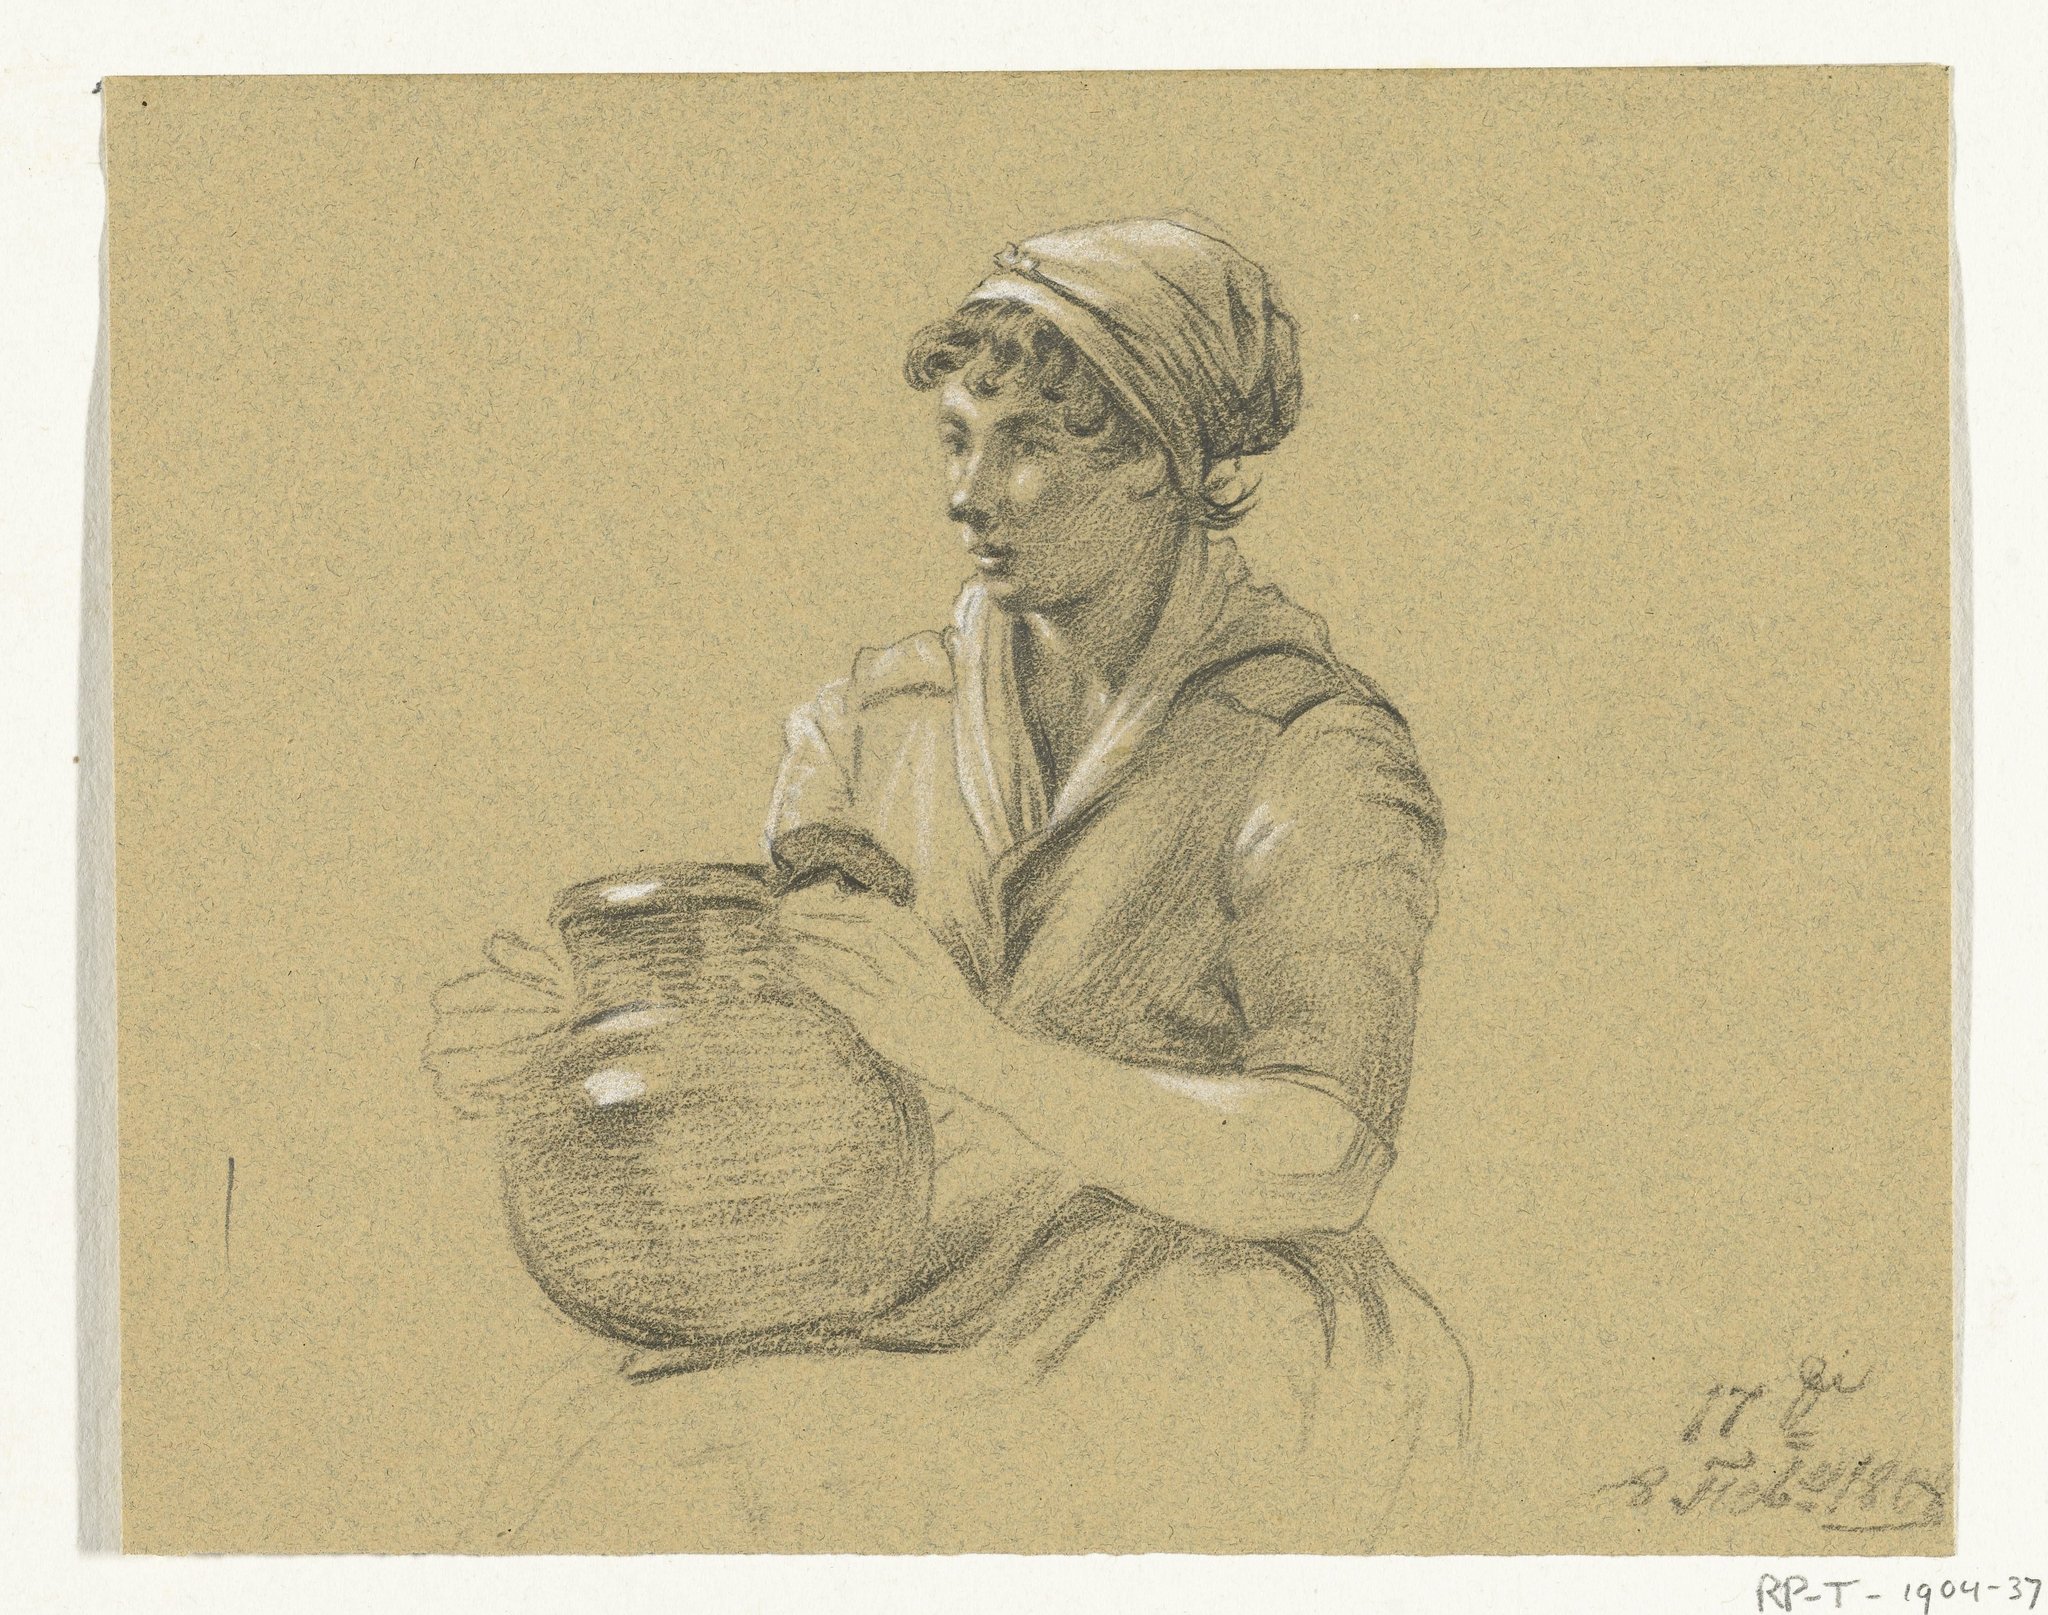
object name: drawing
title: Zittend meisje met een grote kruik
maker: jean bernard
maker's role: draughtsman, print maker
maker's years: 1765-1833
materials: chalk, paper